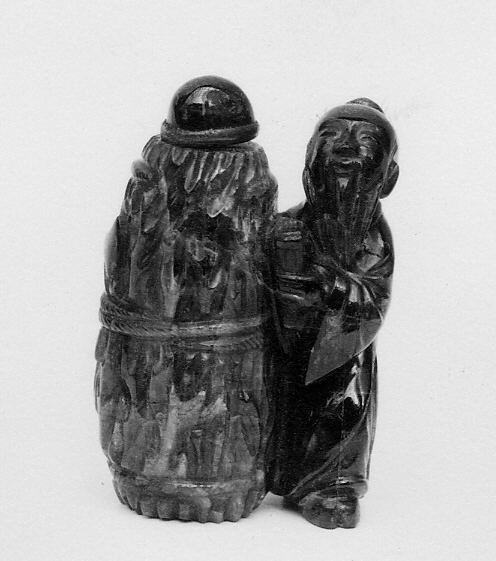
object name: snuff bottle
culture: chinese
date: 1701-1800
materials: gemstone, quartz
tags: men